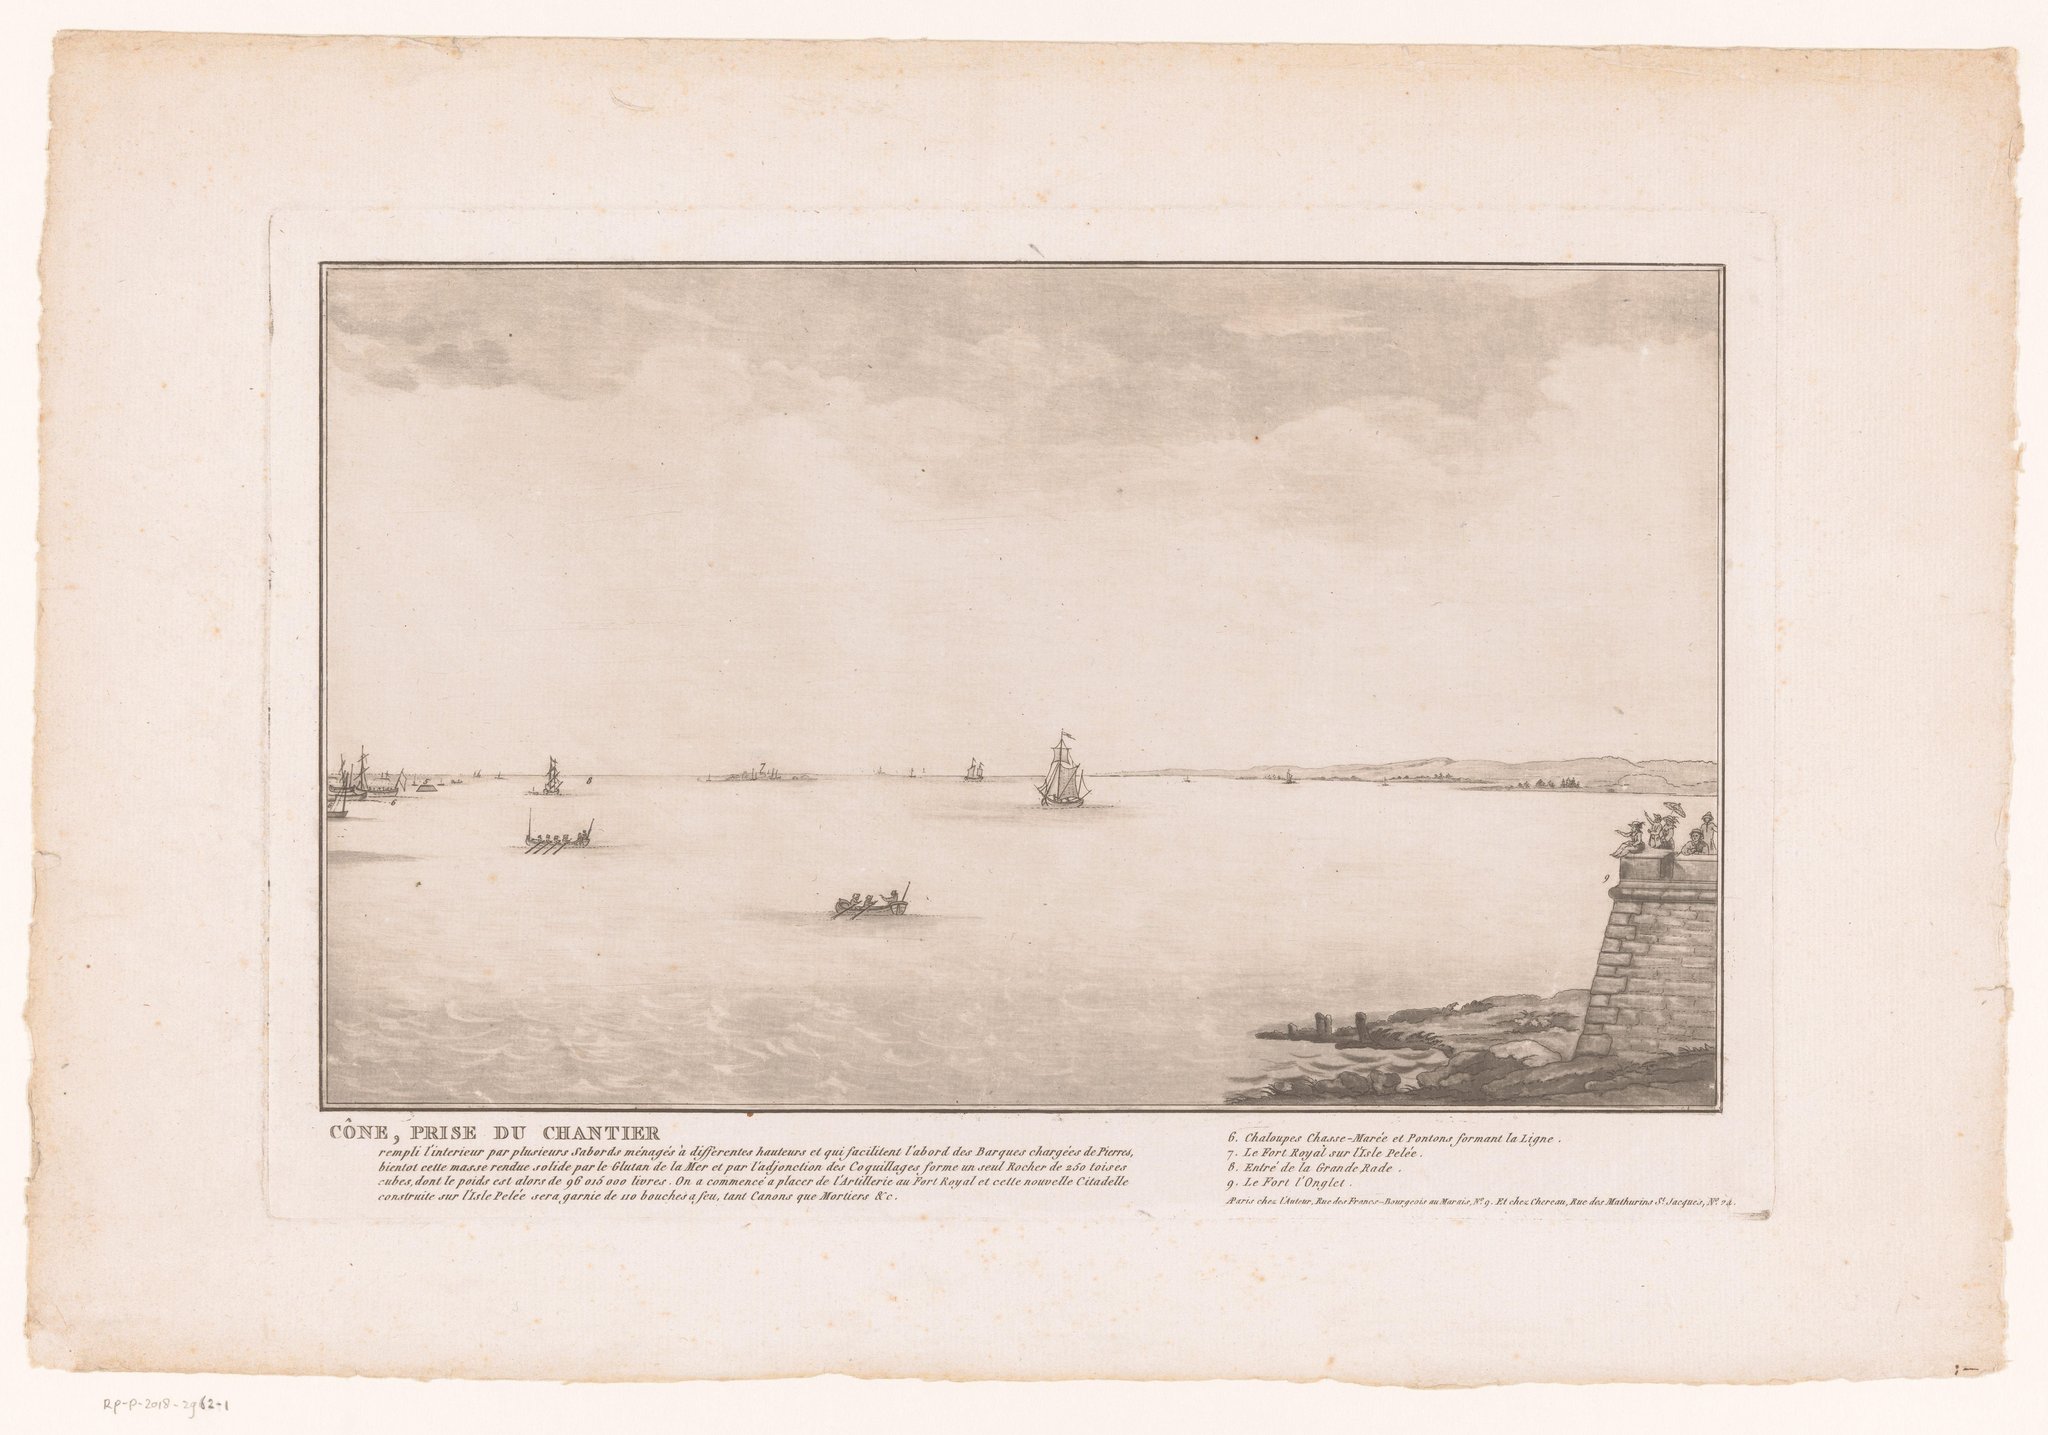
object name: print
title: Vue du départ d'un còne, prise du chantier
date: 1786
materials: paper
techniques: aquatint, etching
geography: paris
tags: pier, quay, wharf, france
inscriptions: collector's mark: Lugt 2228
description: Gezicht op het water met rechts de kade.